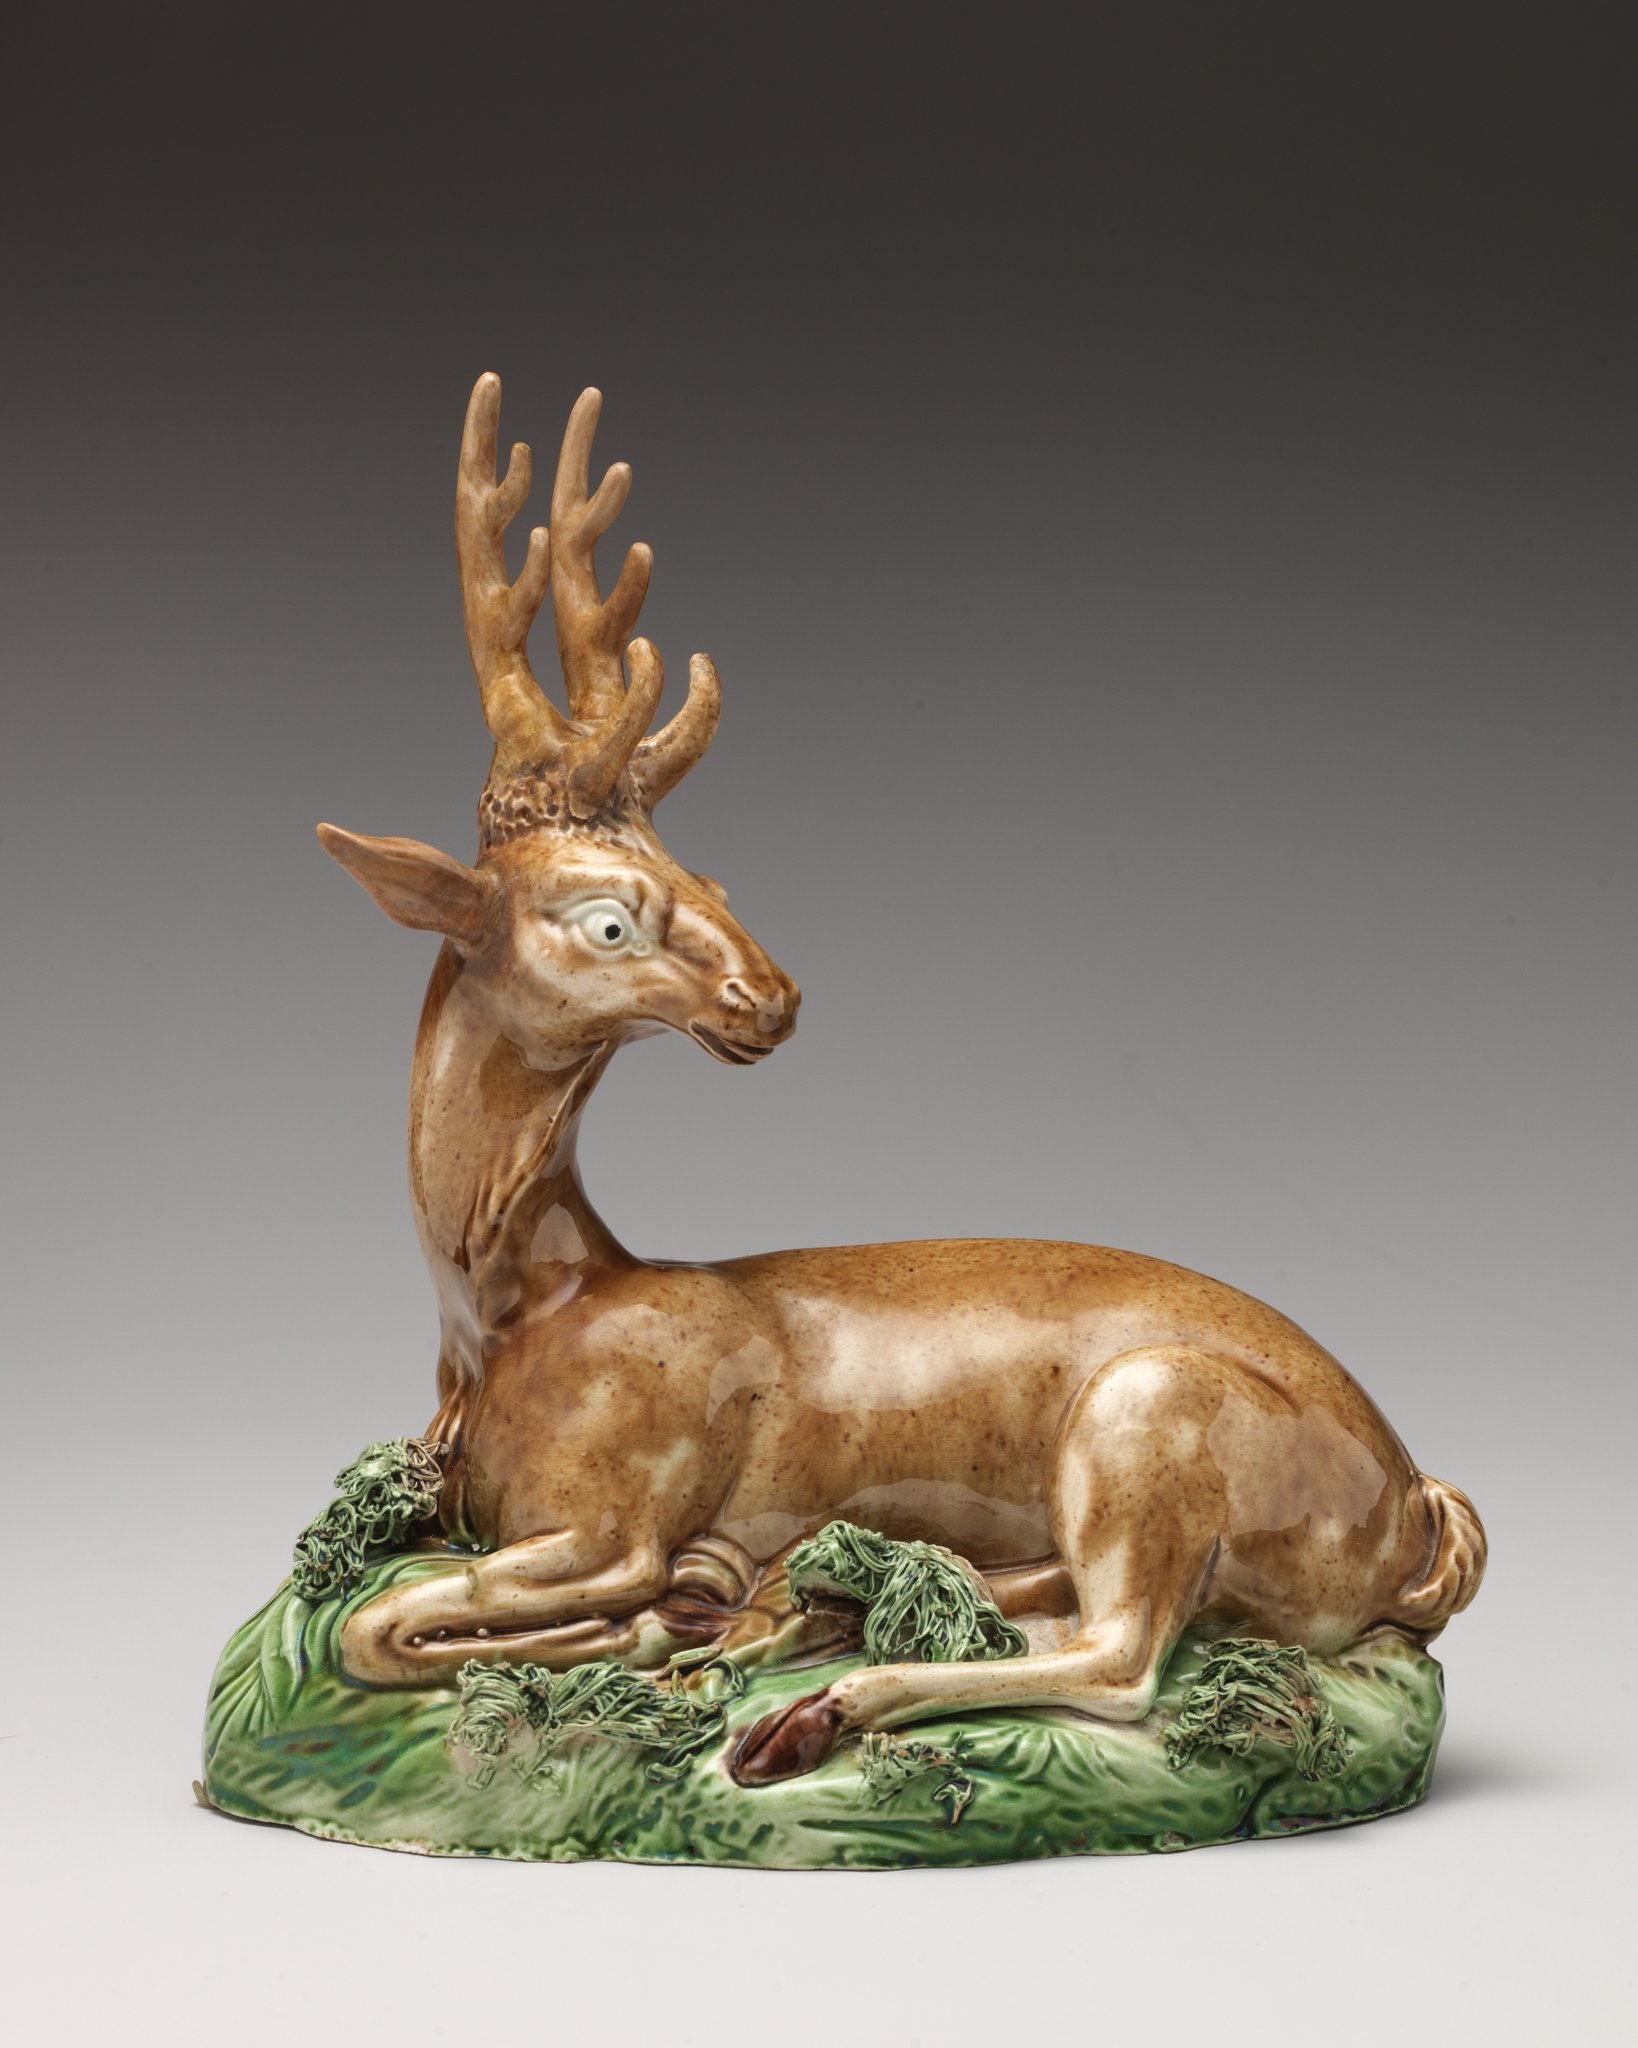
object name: figure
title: Stag (one of a pair)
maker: ralph wood the younger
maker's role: maker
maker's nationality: british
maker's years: 1748-1795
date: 1780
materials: earthenware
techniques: glazing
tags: deer